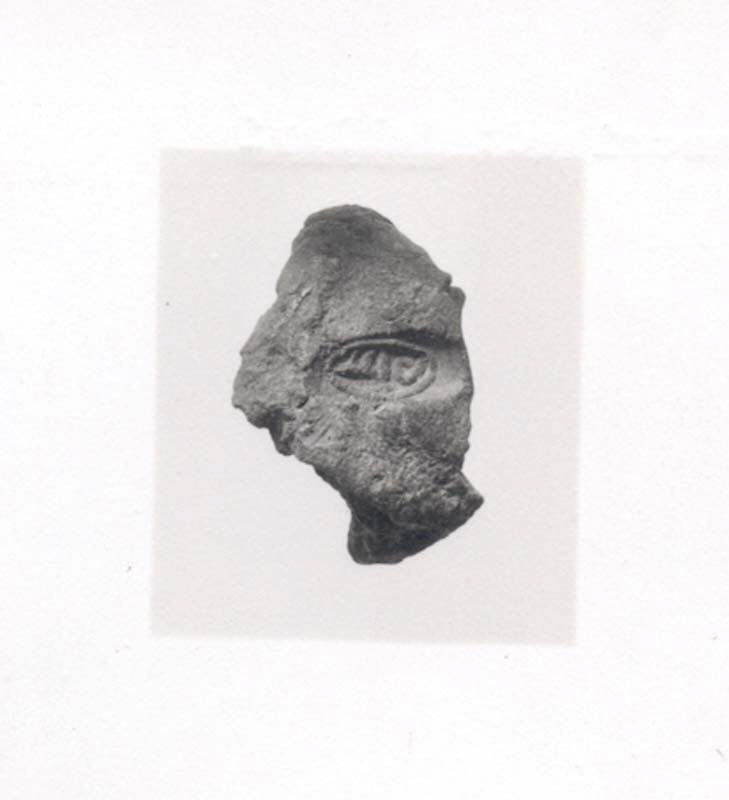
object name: sealing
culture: sasanian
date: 601-700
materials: clay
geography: iran